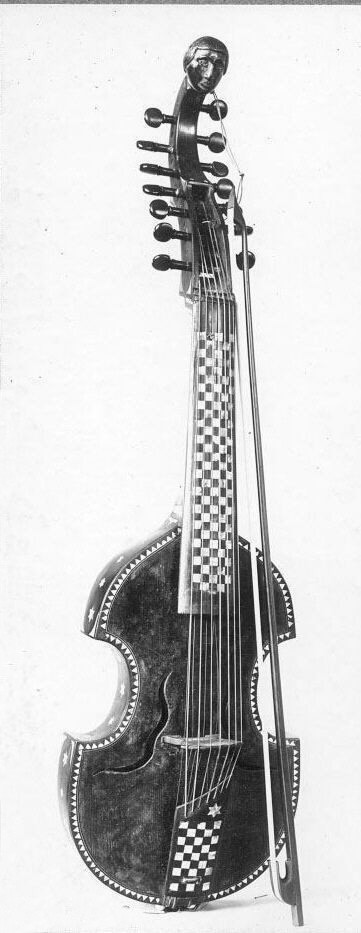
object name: viola d'amore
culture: french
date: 1701-1800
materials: wood, metal, mother of pearl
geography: france